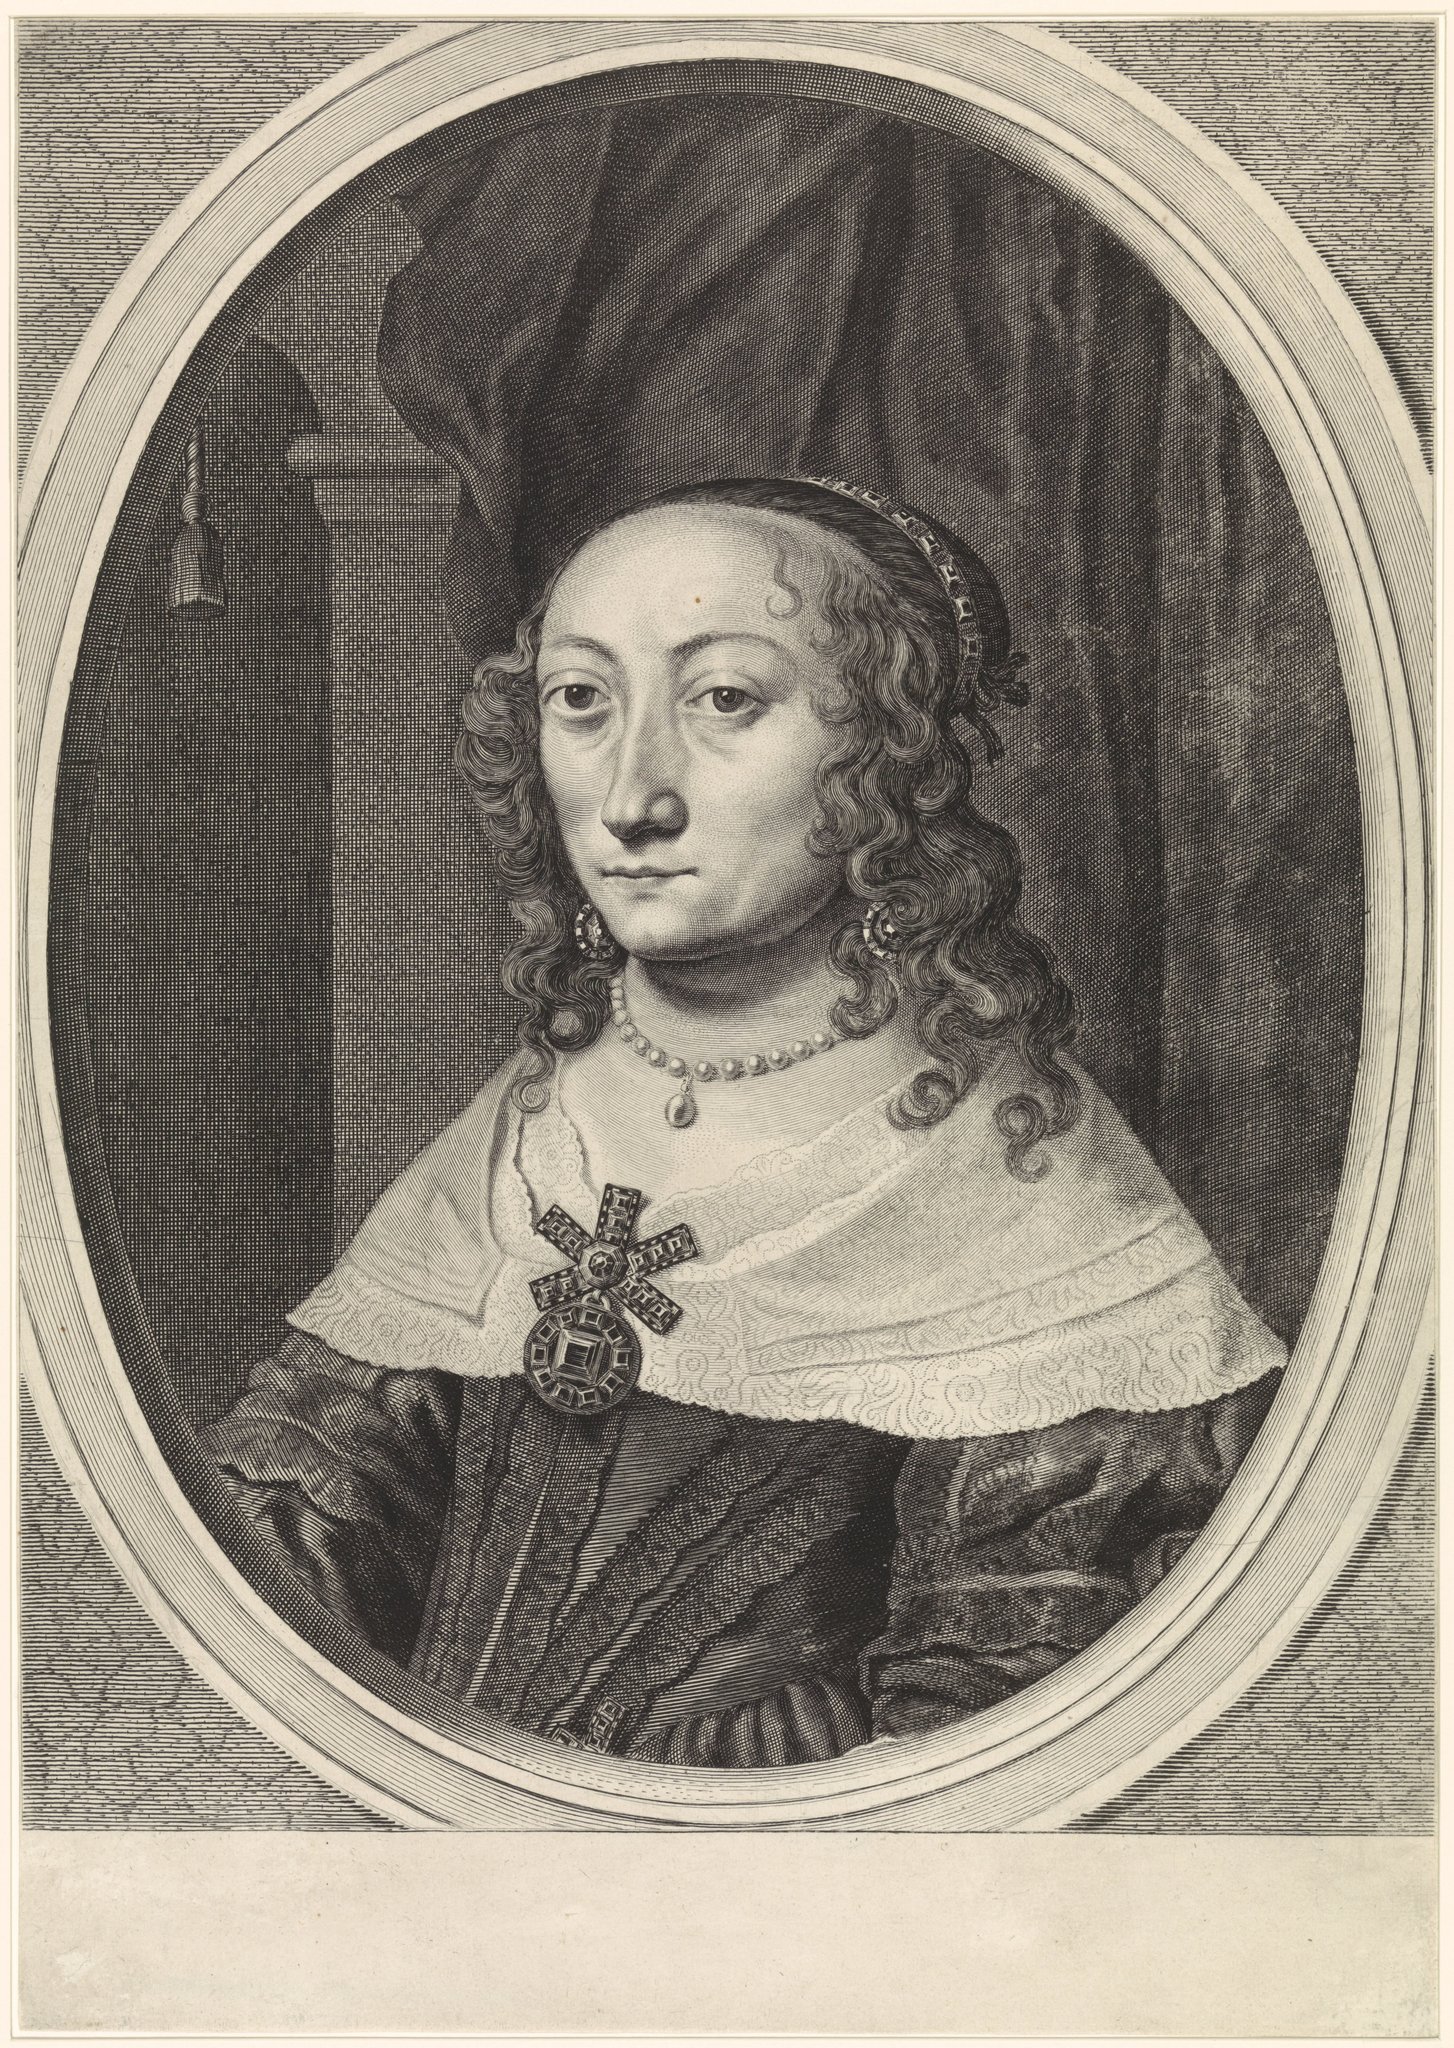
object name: print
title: Portret van Catherina Charlotta, paltsgravin van Palts-Neuburg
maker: theodor matham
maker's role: draughtsman, print maker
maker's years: 1605-1676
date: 1635-1653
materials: paper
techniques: engraving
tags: ear-rings (+ women's clothes), brooch, agraffe, clasp (+ women's clothes), necklace (+ women's clothes)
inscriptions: collector's mark: Lugt 2228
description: Portret van Catherina Charlotta, paltsgravin van Palts-Neuburg, vrouw van Wolfgang Willem van de Palts-Neuburg. Om haar hals een parelsnoer met een hanger en op haar borst een juwelen speld.